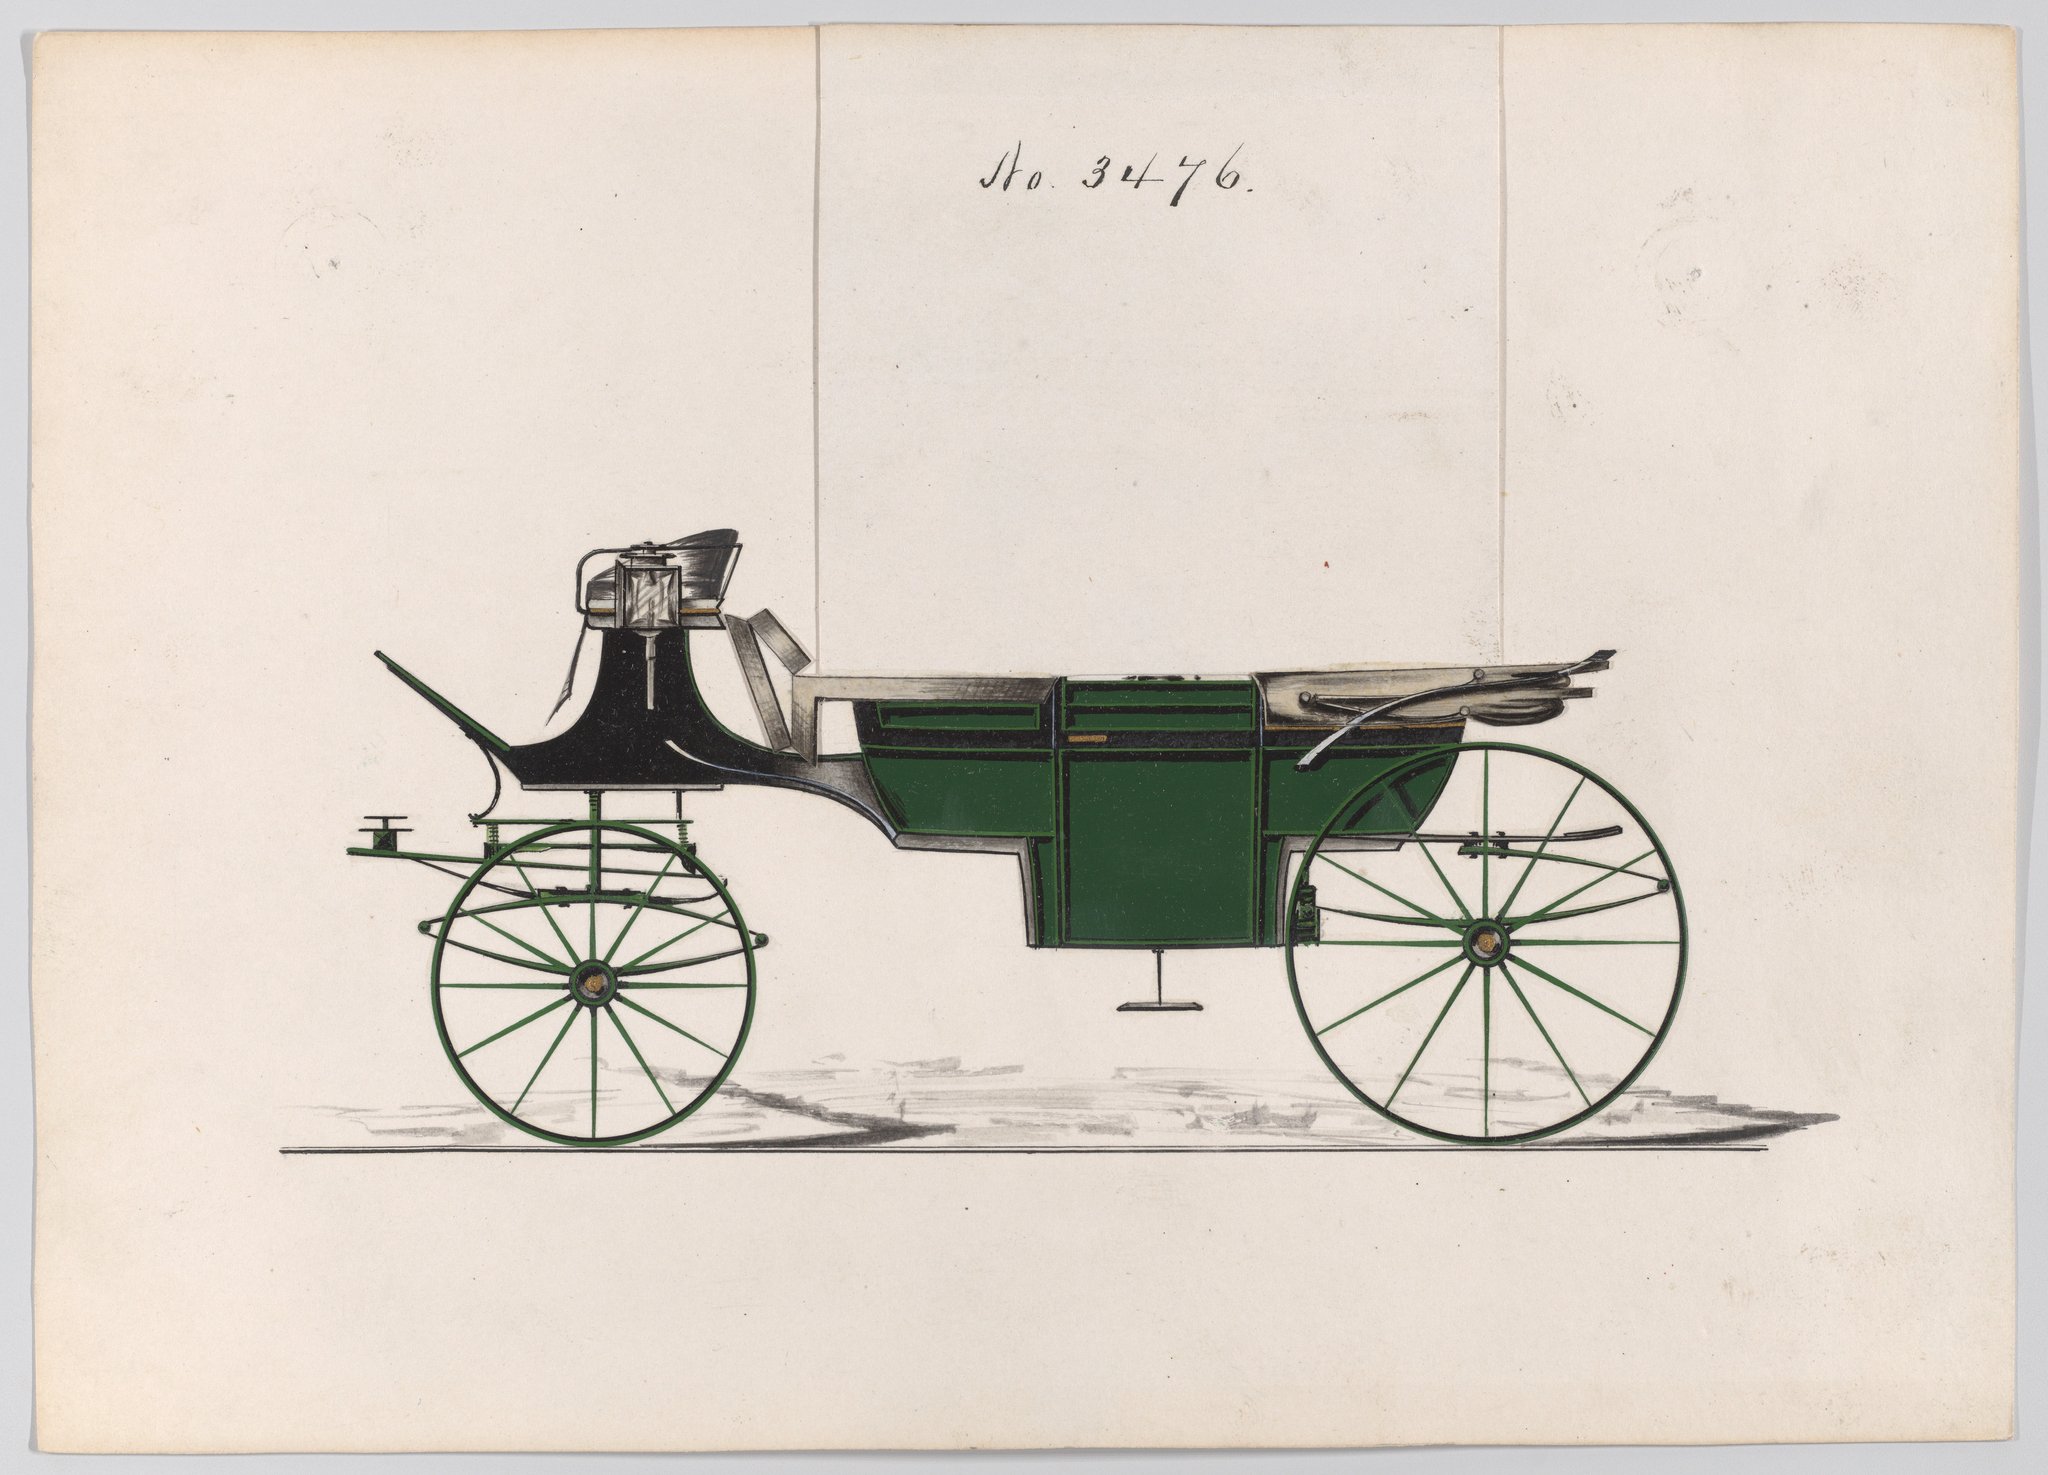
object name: drawing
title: Design for Landau, No. 3476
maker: brewster & co.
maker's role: manufacturer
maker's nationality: american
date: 1878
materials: gouache, gum arabic, ink, watercolor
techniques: pen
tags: carriages